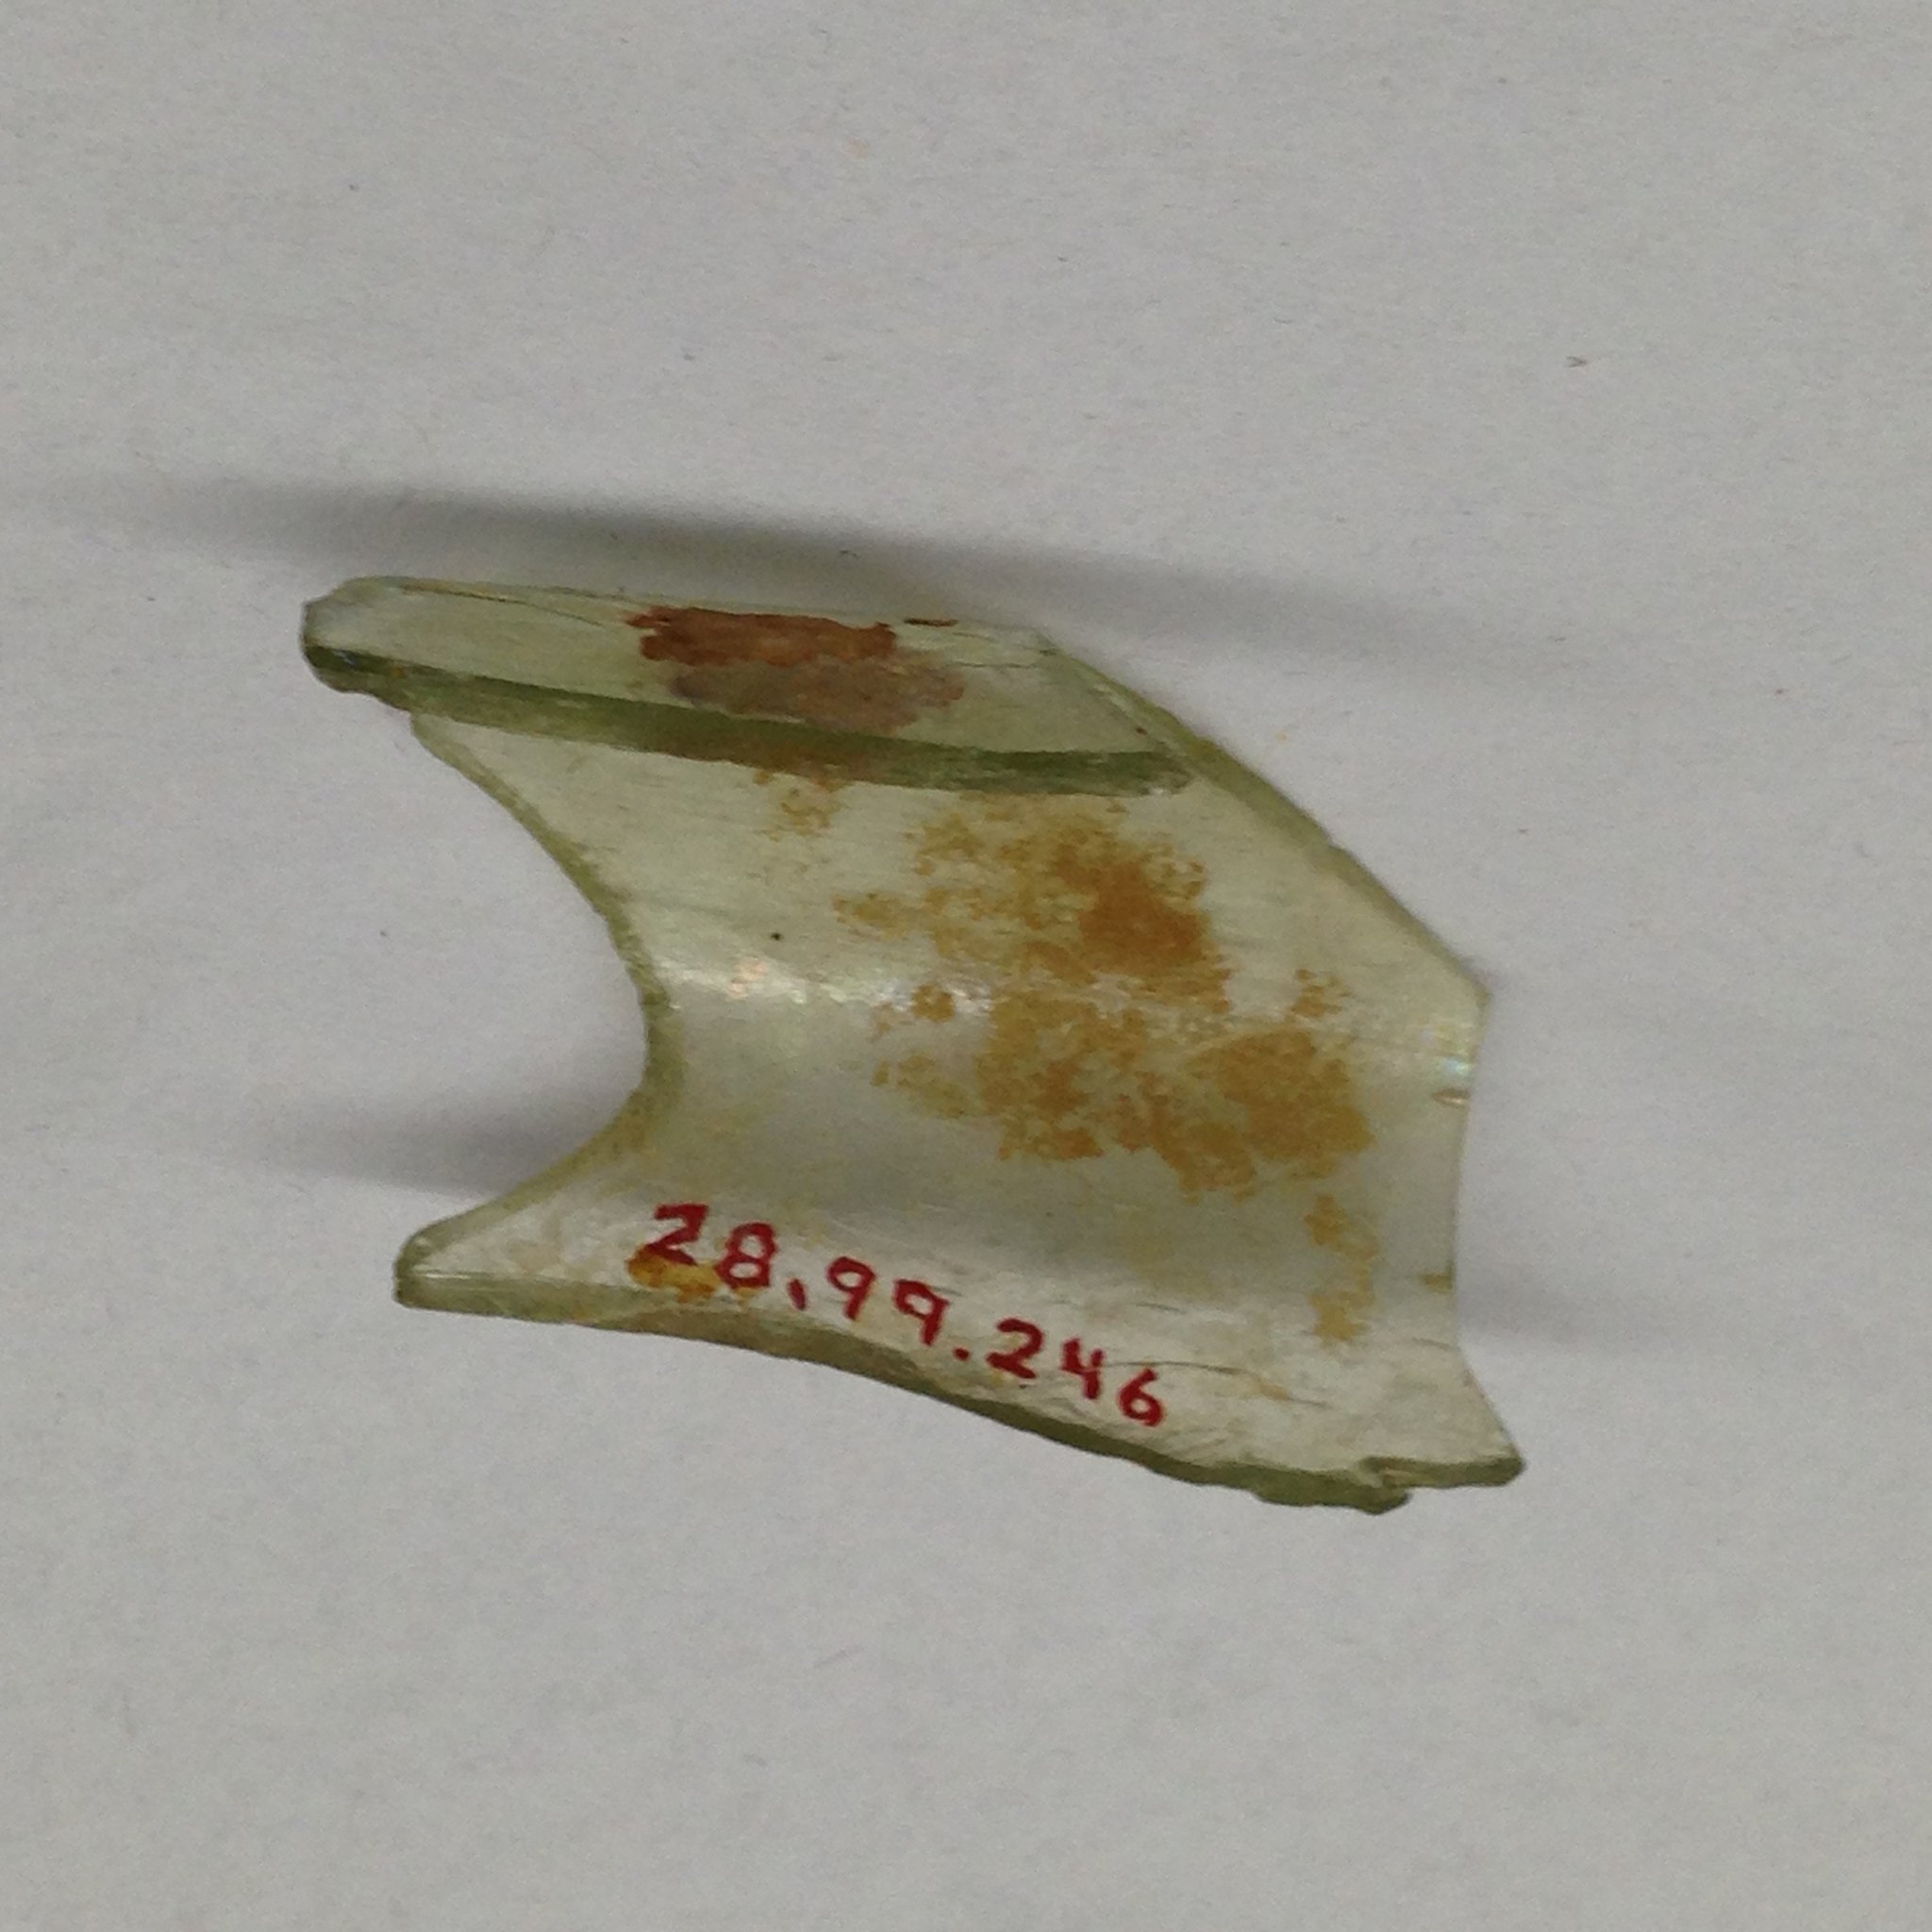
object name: fragment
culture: european or middle eastern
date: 1150-1250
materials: ceramic, glass